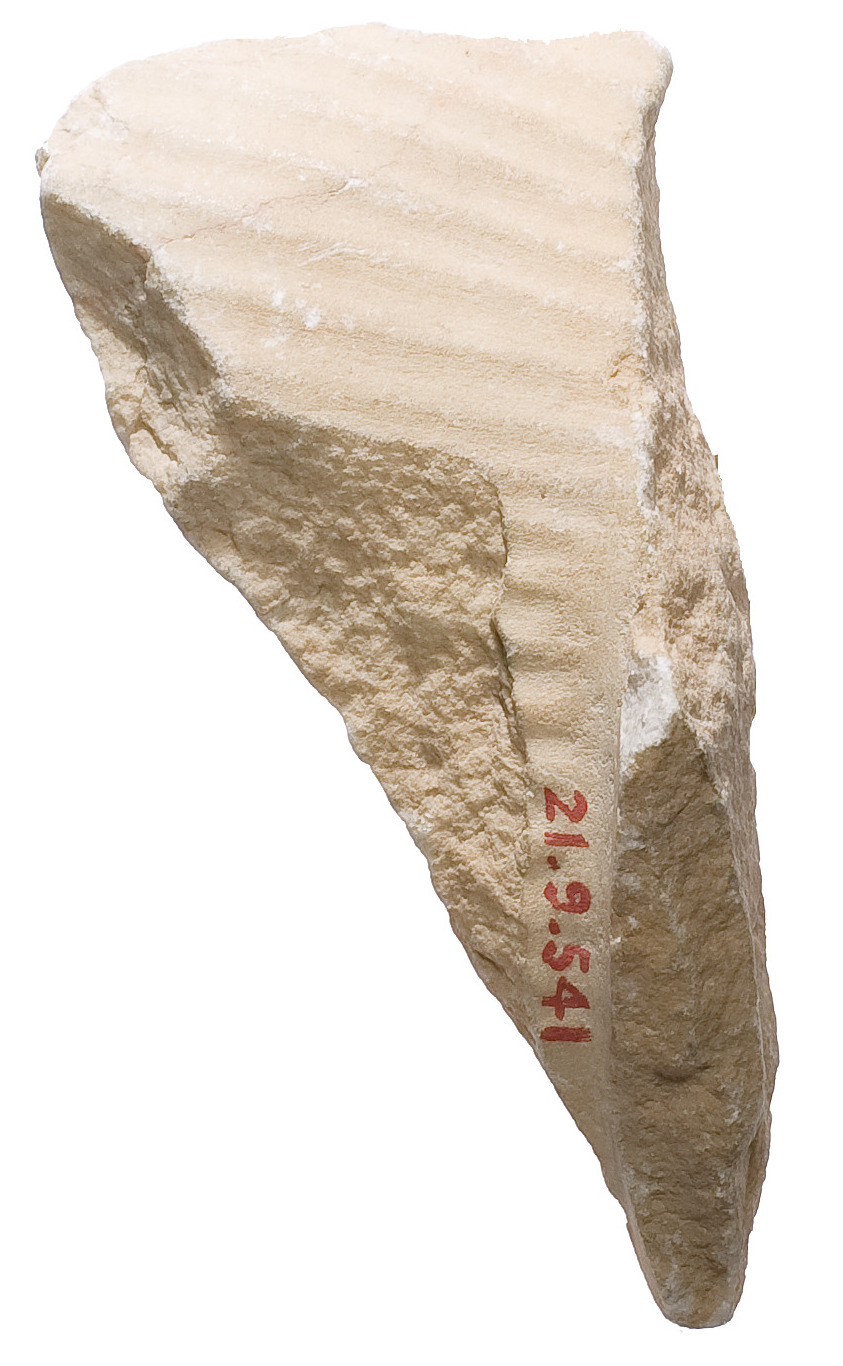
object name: back, shoulder, garment, pleating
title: Back of shoulder with shawl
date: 1353-1336 BCE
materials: limestone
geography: egypt